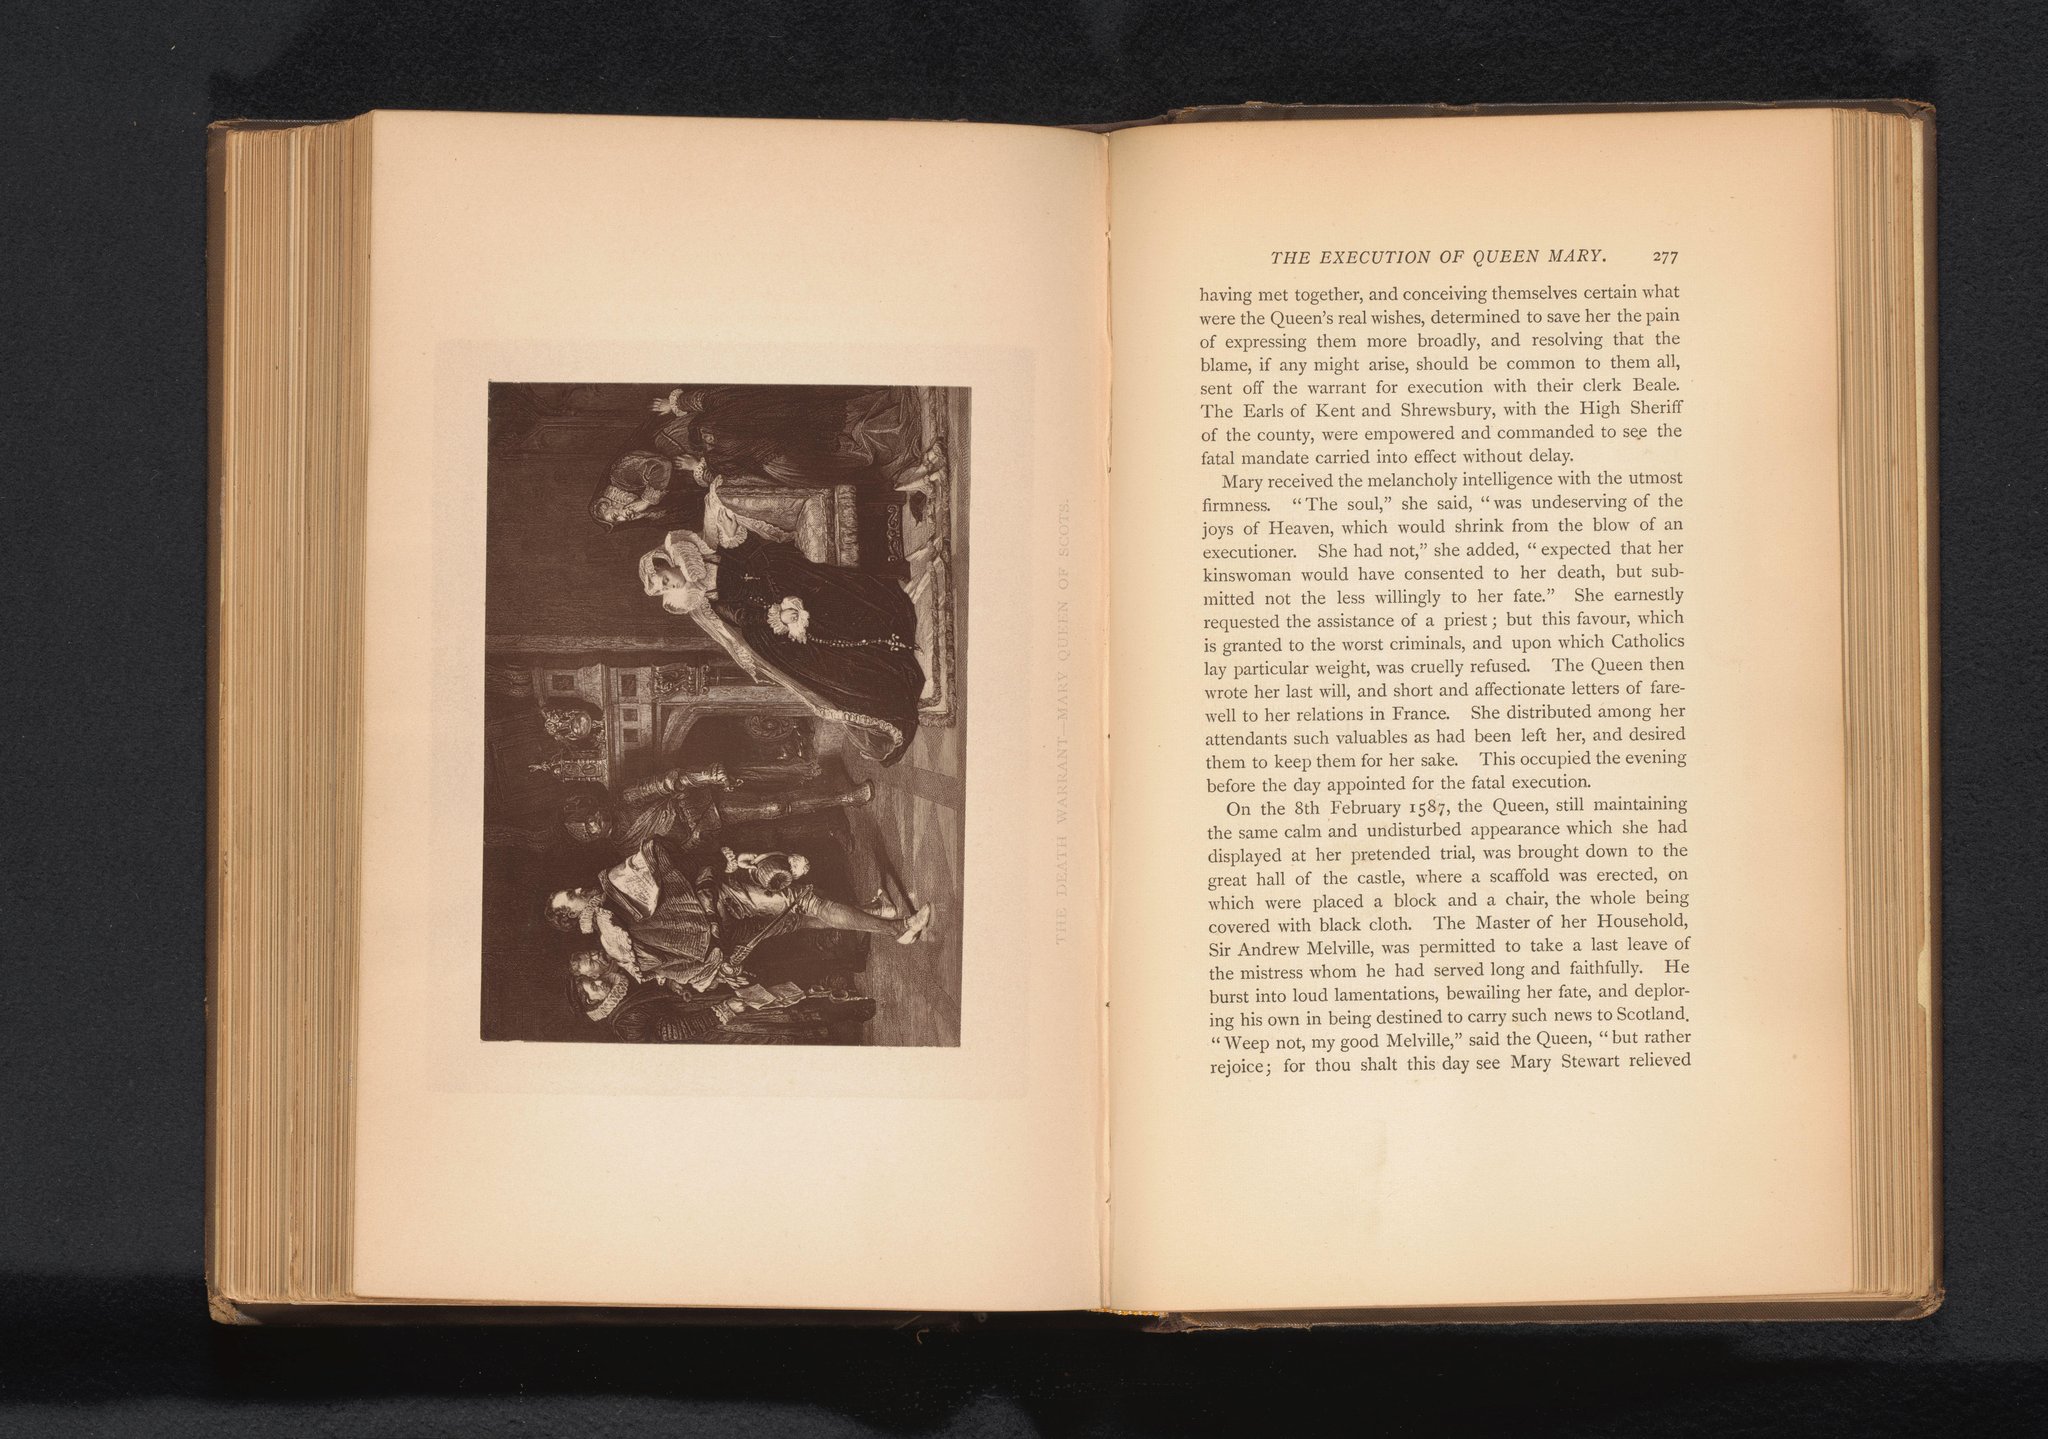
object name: reproduction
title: The death warrant-Mary queen of Scots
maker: Anonymous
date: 1876-1881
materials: paper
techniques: woodburytype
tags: soldier with warrant, ruler, sovereign - bb - female ruler